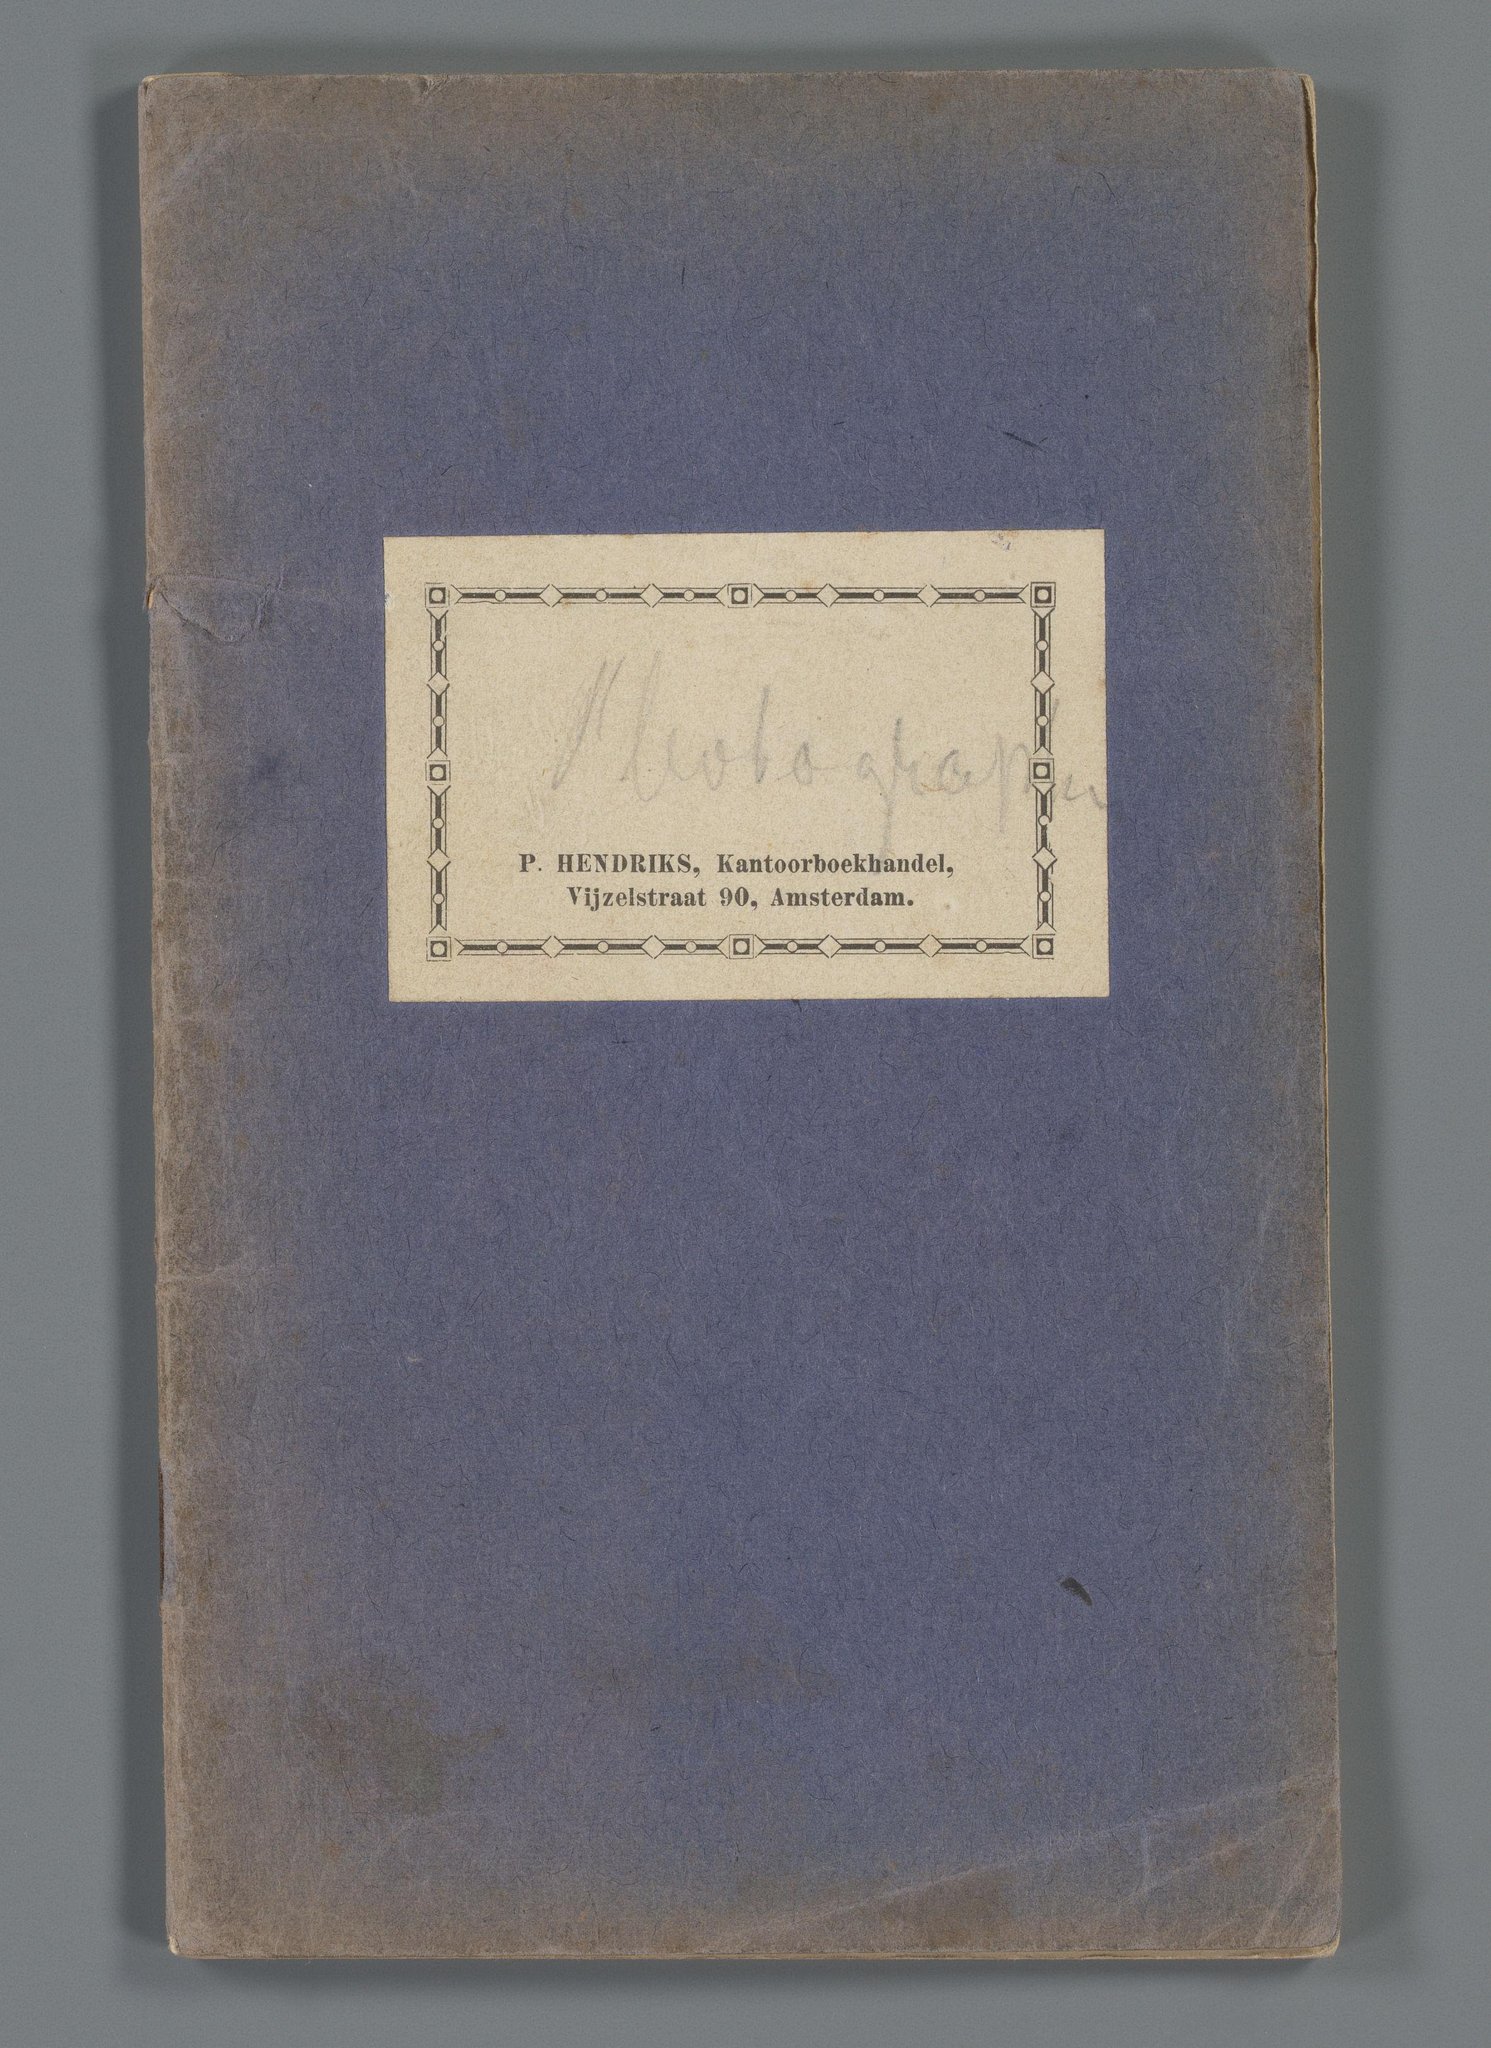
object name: exercise book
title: Photographien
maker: jacob olie jr.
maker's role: fotograaf, scheikundige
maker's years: 1879-1955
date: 1900-1902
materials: ink, paper, pencil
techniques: pen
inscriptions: inscription: ‘P. HENDRIKS, Kantoorboekhandel,/ Vijzelstraat 90, Amsterdam.’